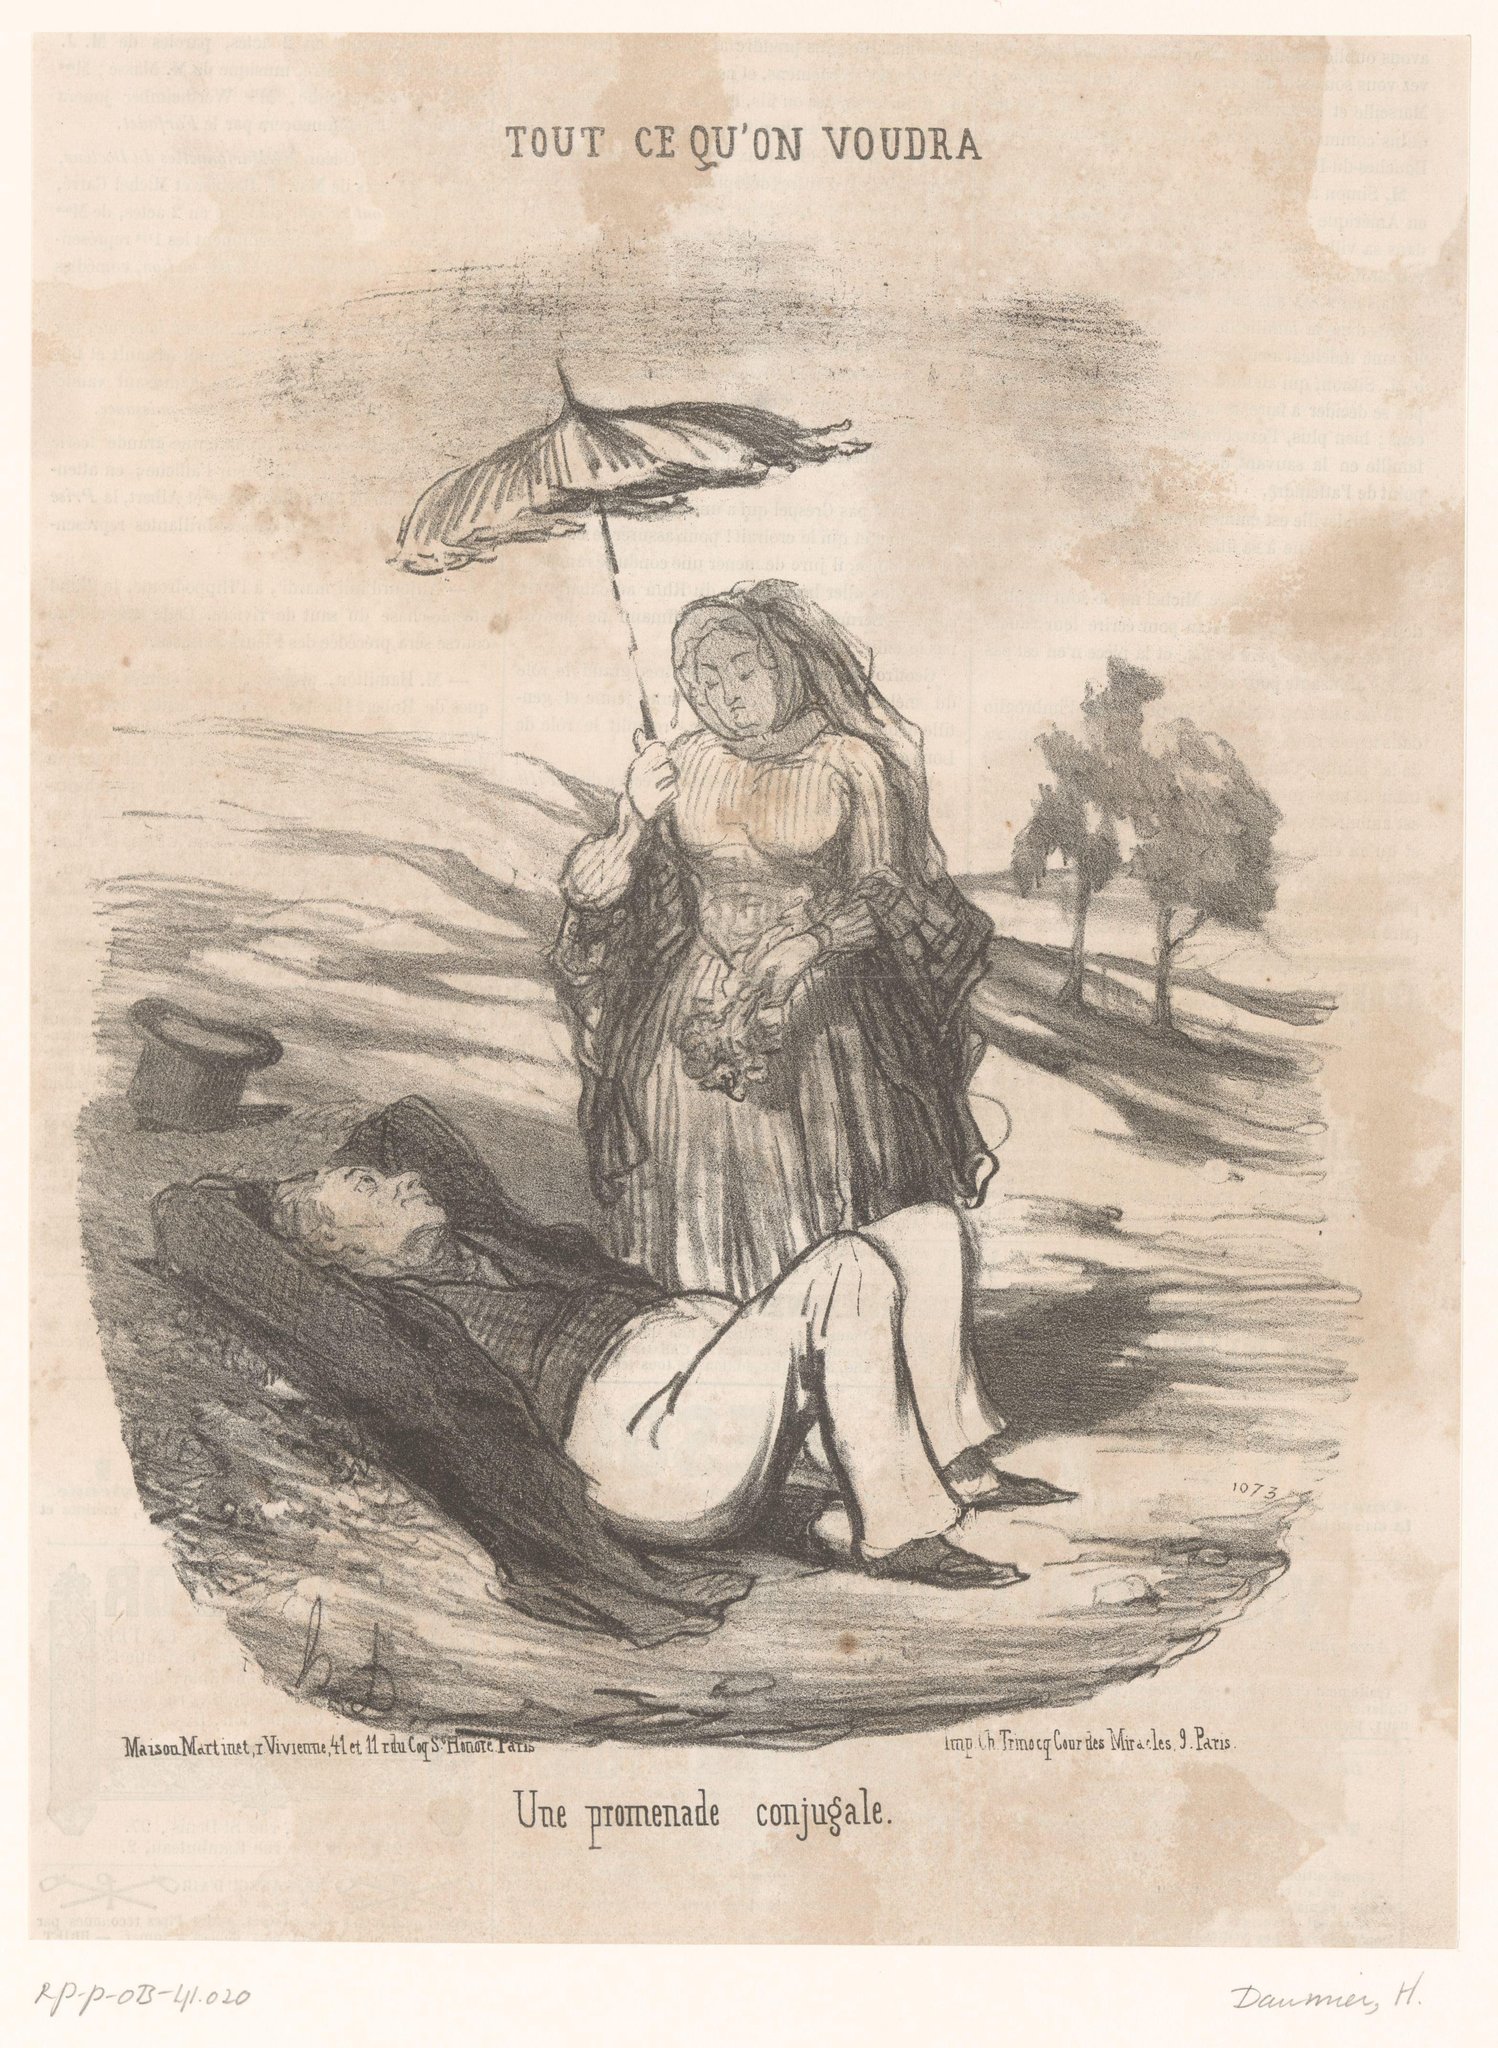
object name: cartoon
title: Tout ce qu'on voudra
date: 1852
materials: paper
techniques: lithograph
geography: paris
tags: caricatures (human types), marriage, married couple, 'matrimonium', resting - bb - out of doors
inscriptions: collector's mark: Lugt 2228a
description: Prent gebruikt voor: Le Charivari, 18 mei 1852.